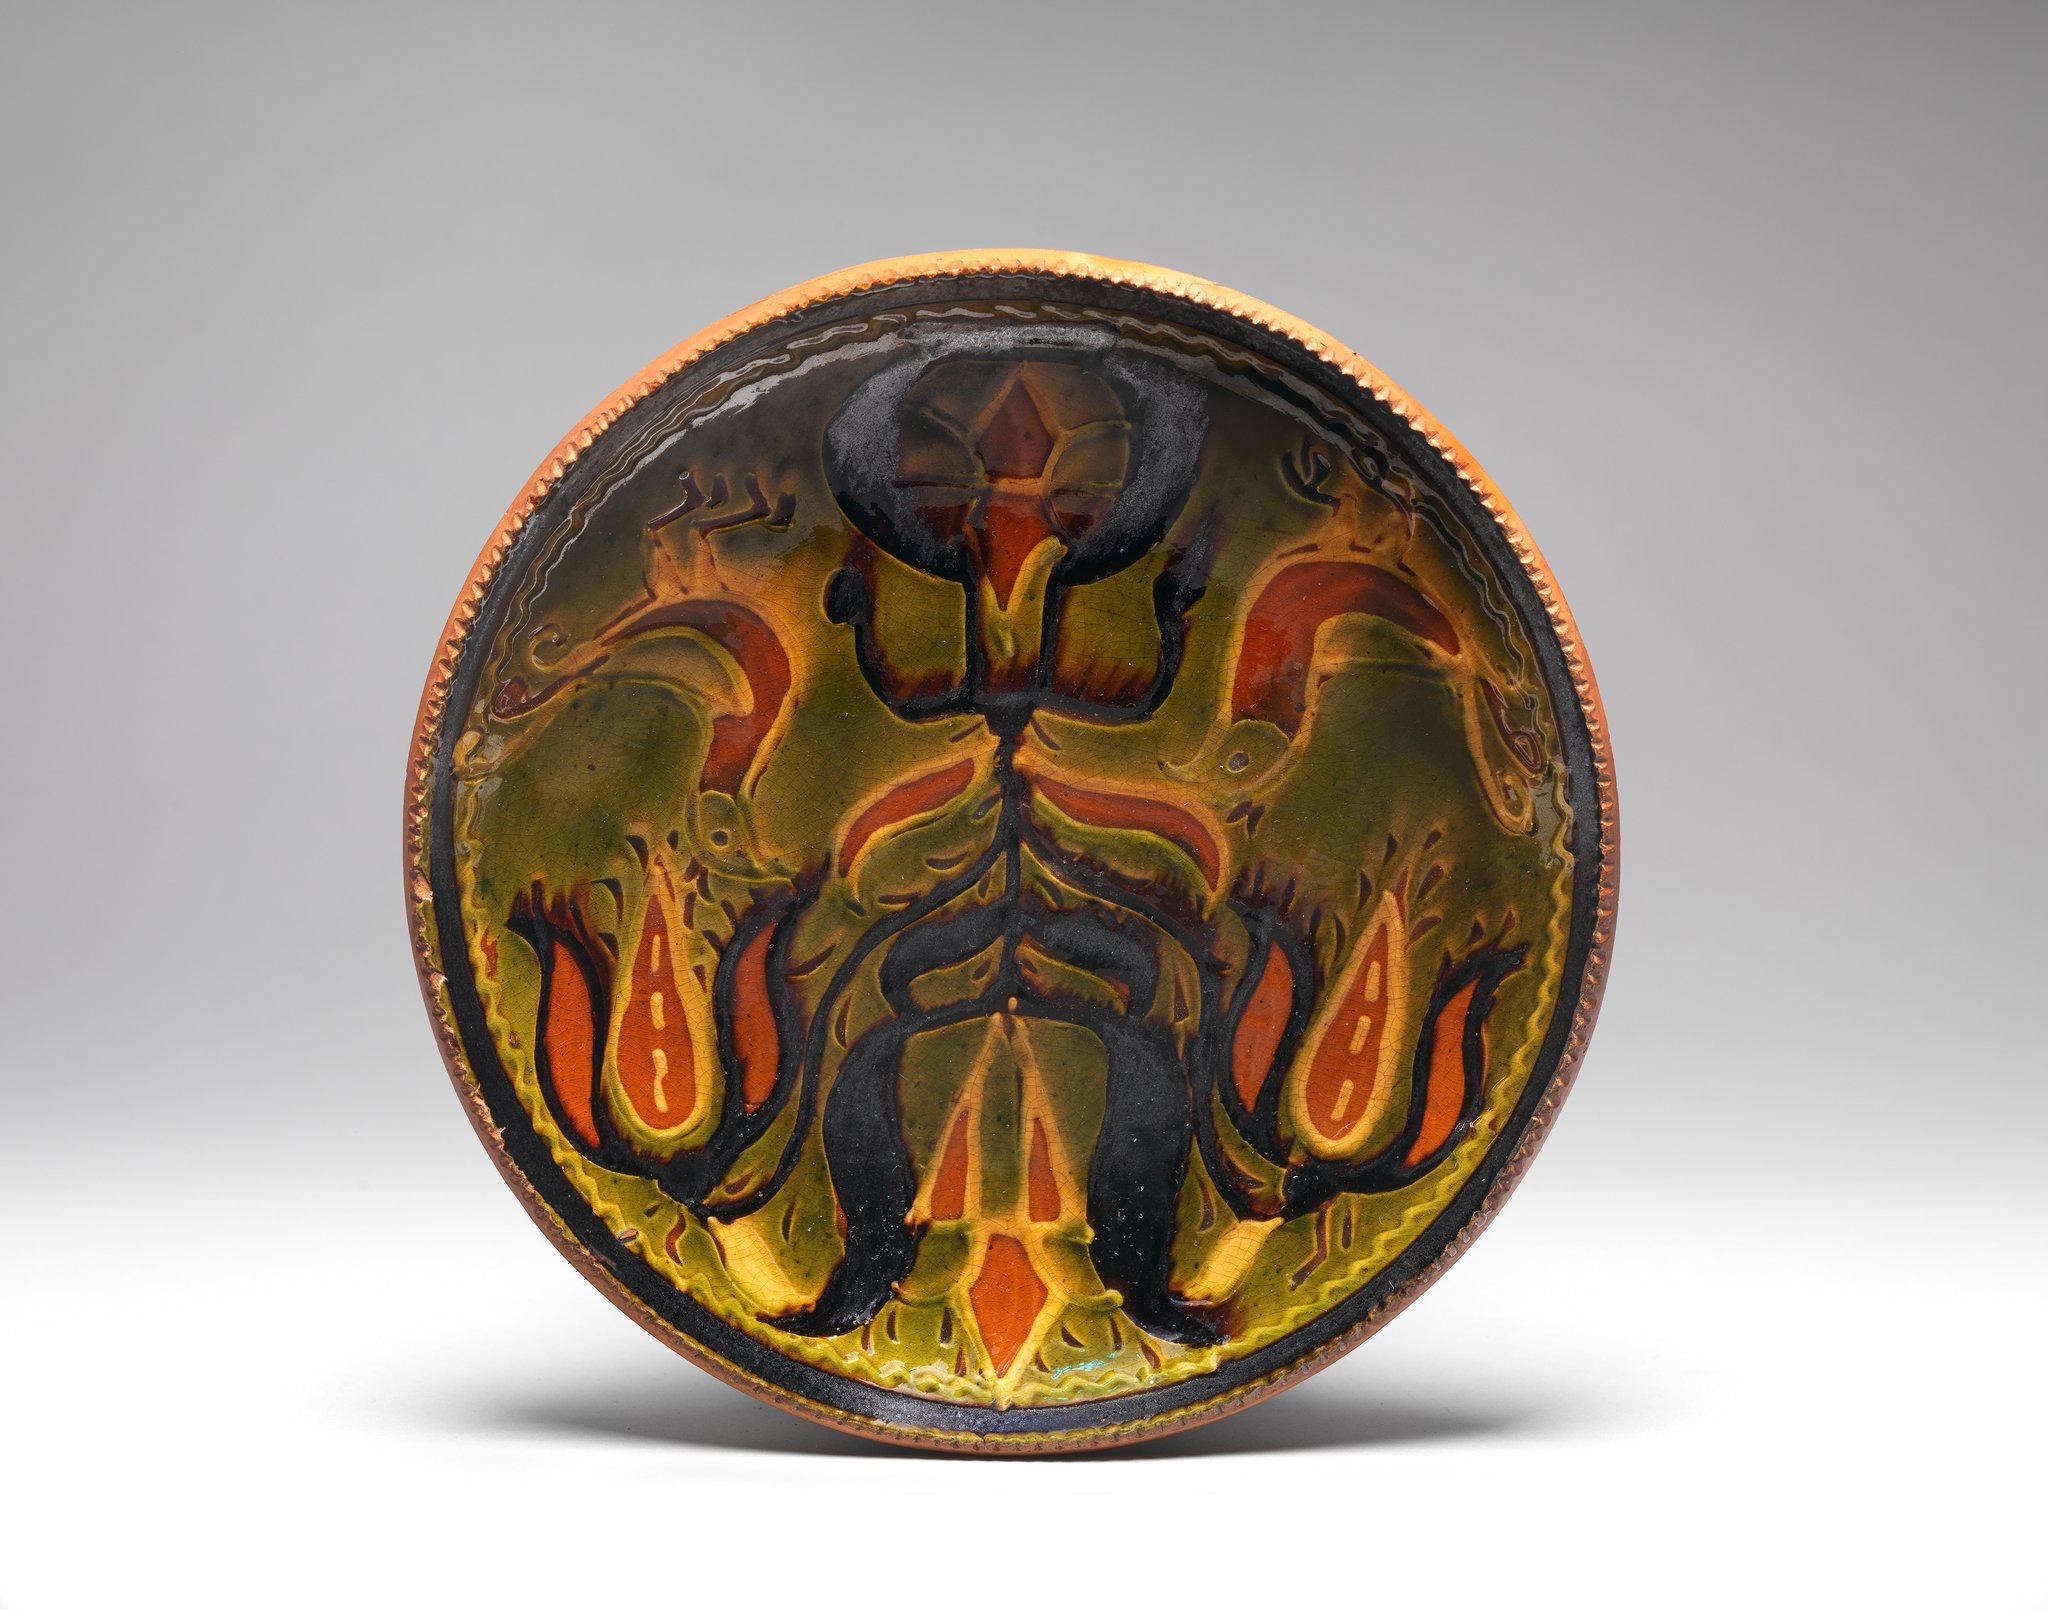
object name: plate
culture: american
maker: solomon grimm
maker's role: maker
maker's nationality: american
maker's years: 1787-1847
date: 1815-1825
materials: earthenware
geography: united states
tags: flowers